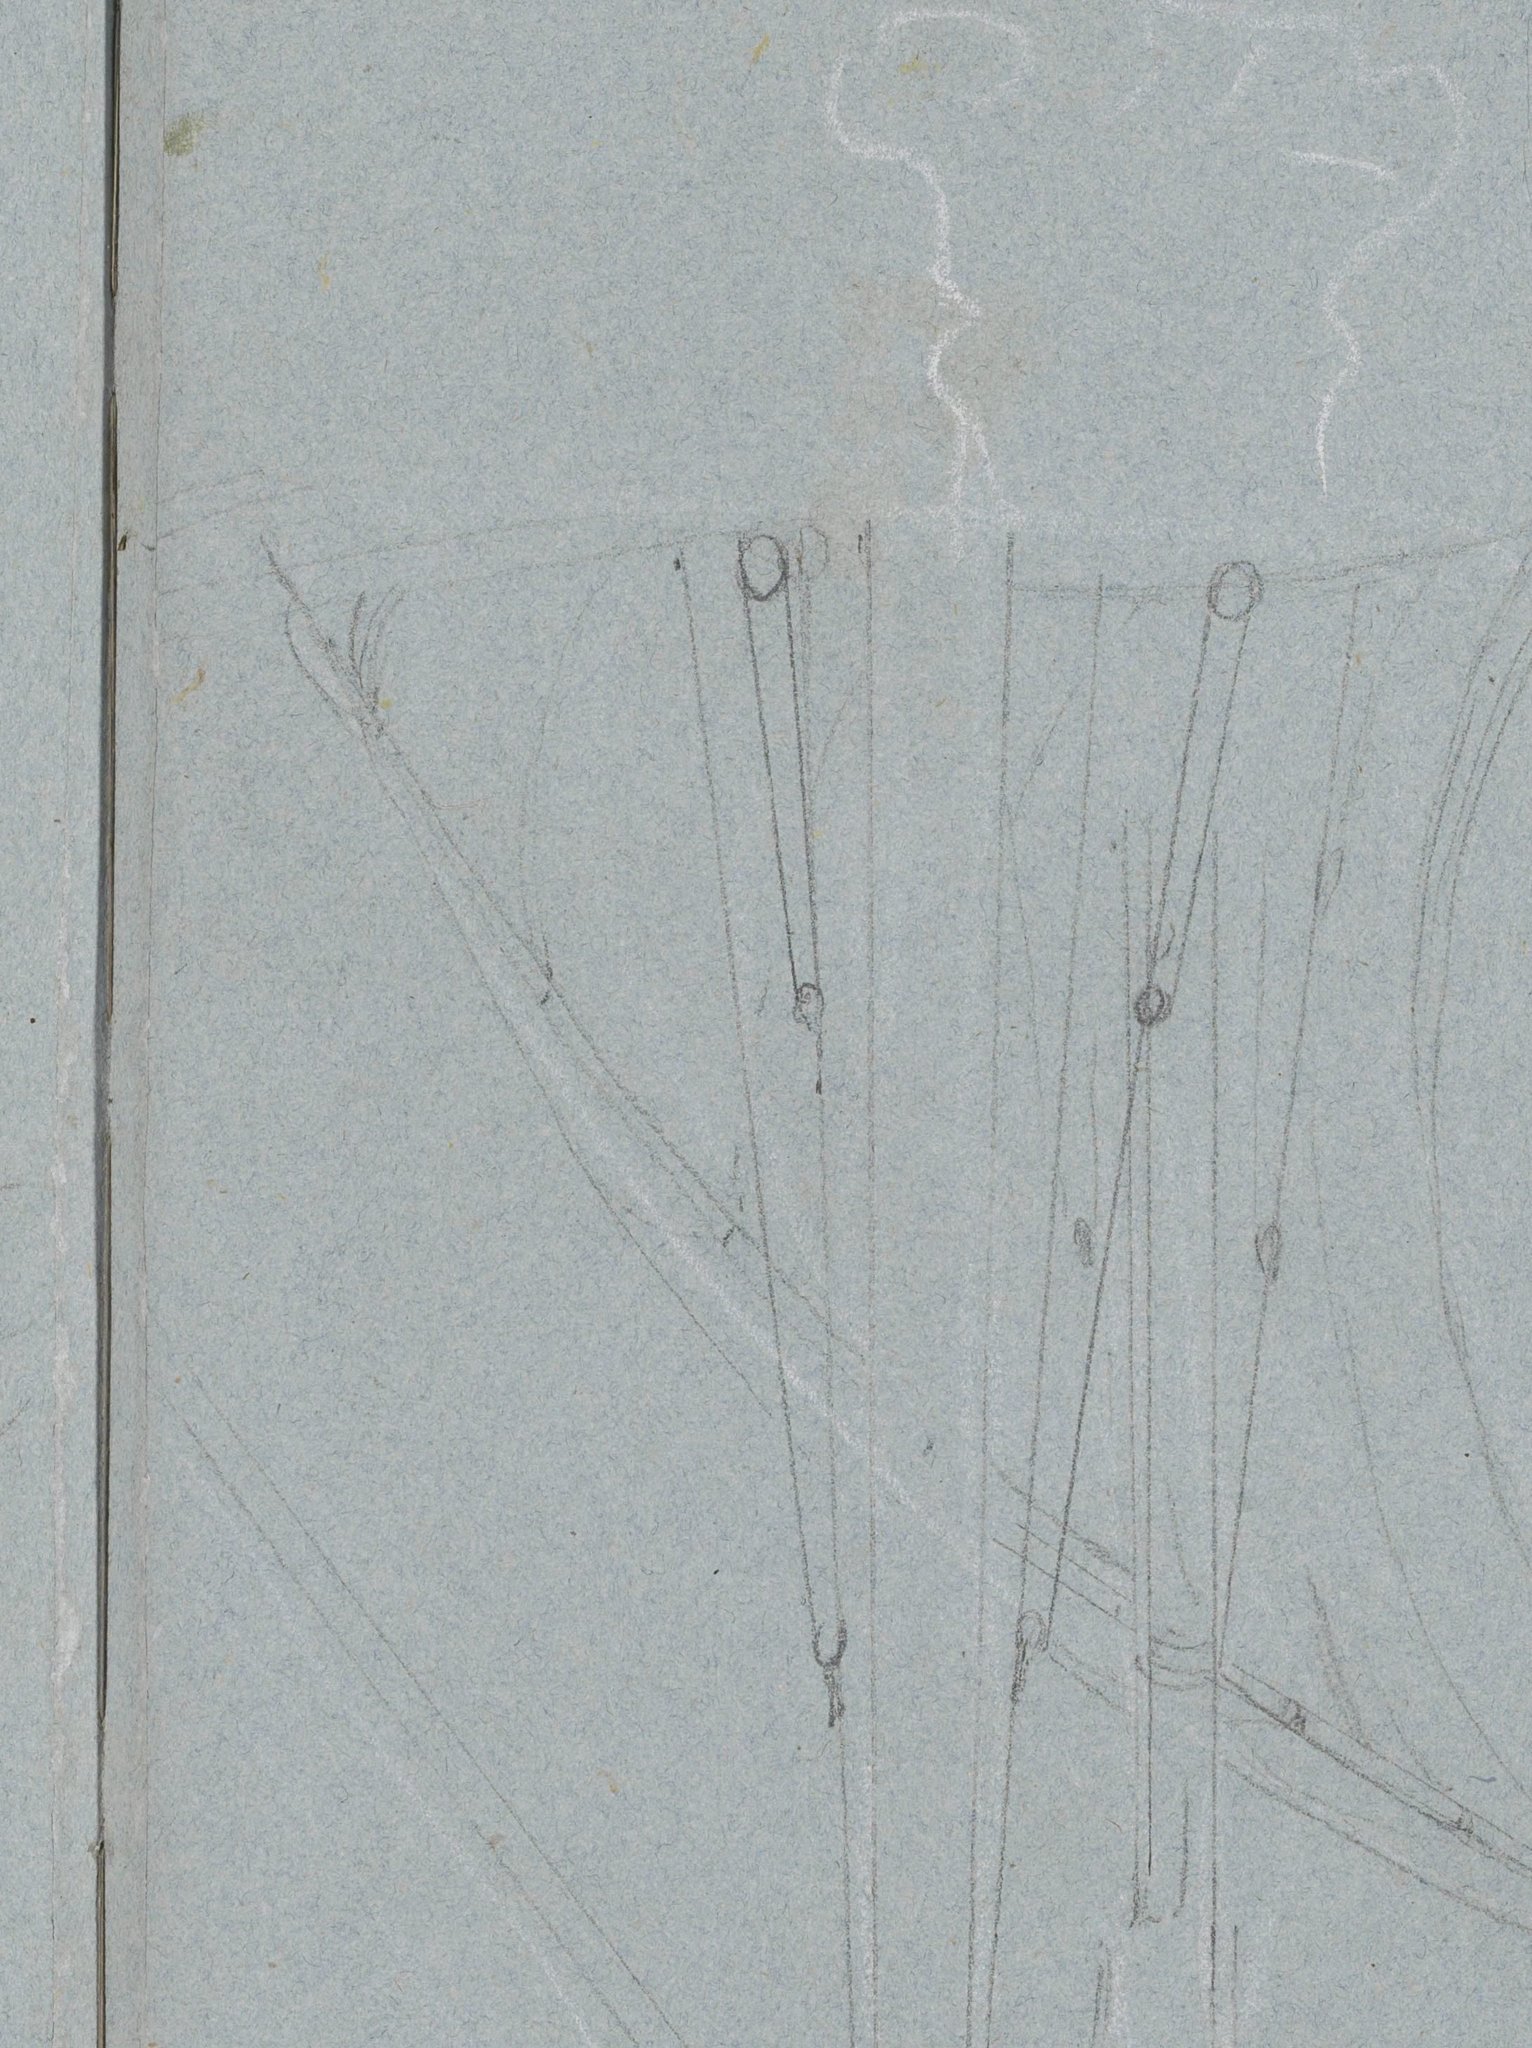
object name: sketchbook leaf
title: Studie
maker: lorenzo baldissera tiepolo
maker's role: draughtsman, print maker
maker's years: 1736-1776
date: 1751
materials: chalk, paper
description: Vermoedelijk een gespannen stof, mogelijk een zeildoek, en masten. Bladzijde 5 uit een schetsboek met 158 bladzijden.